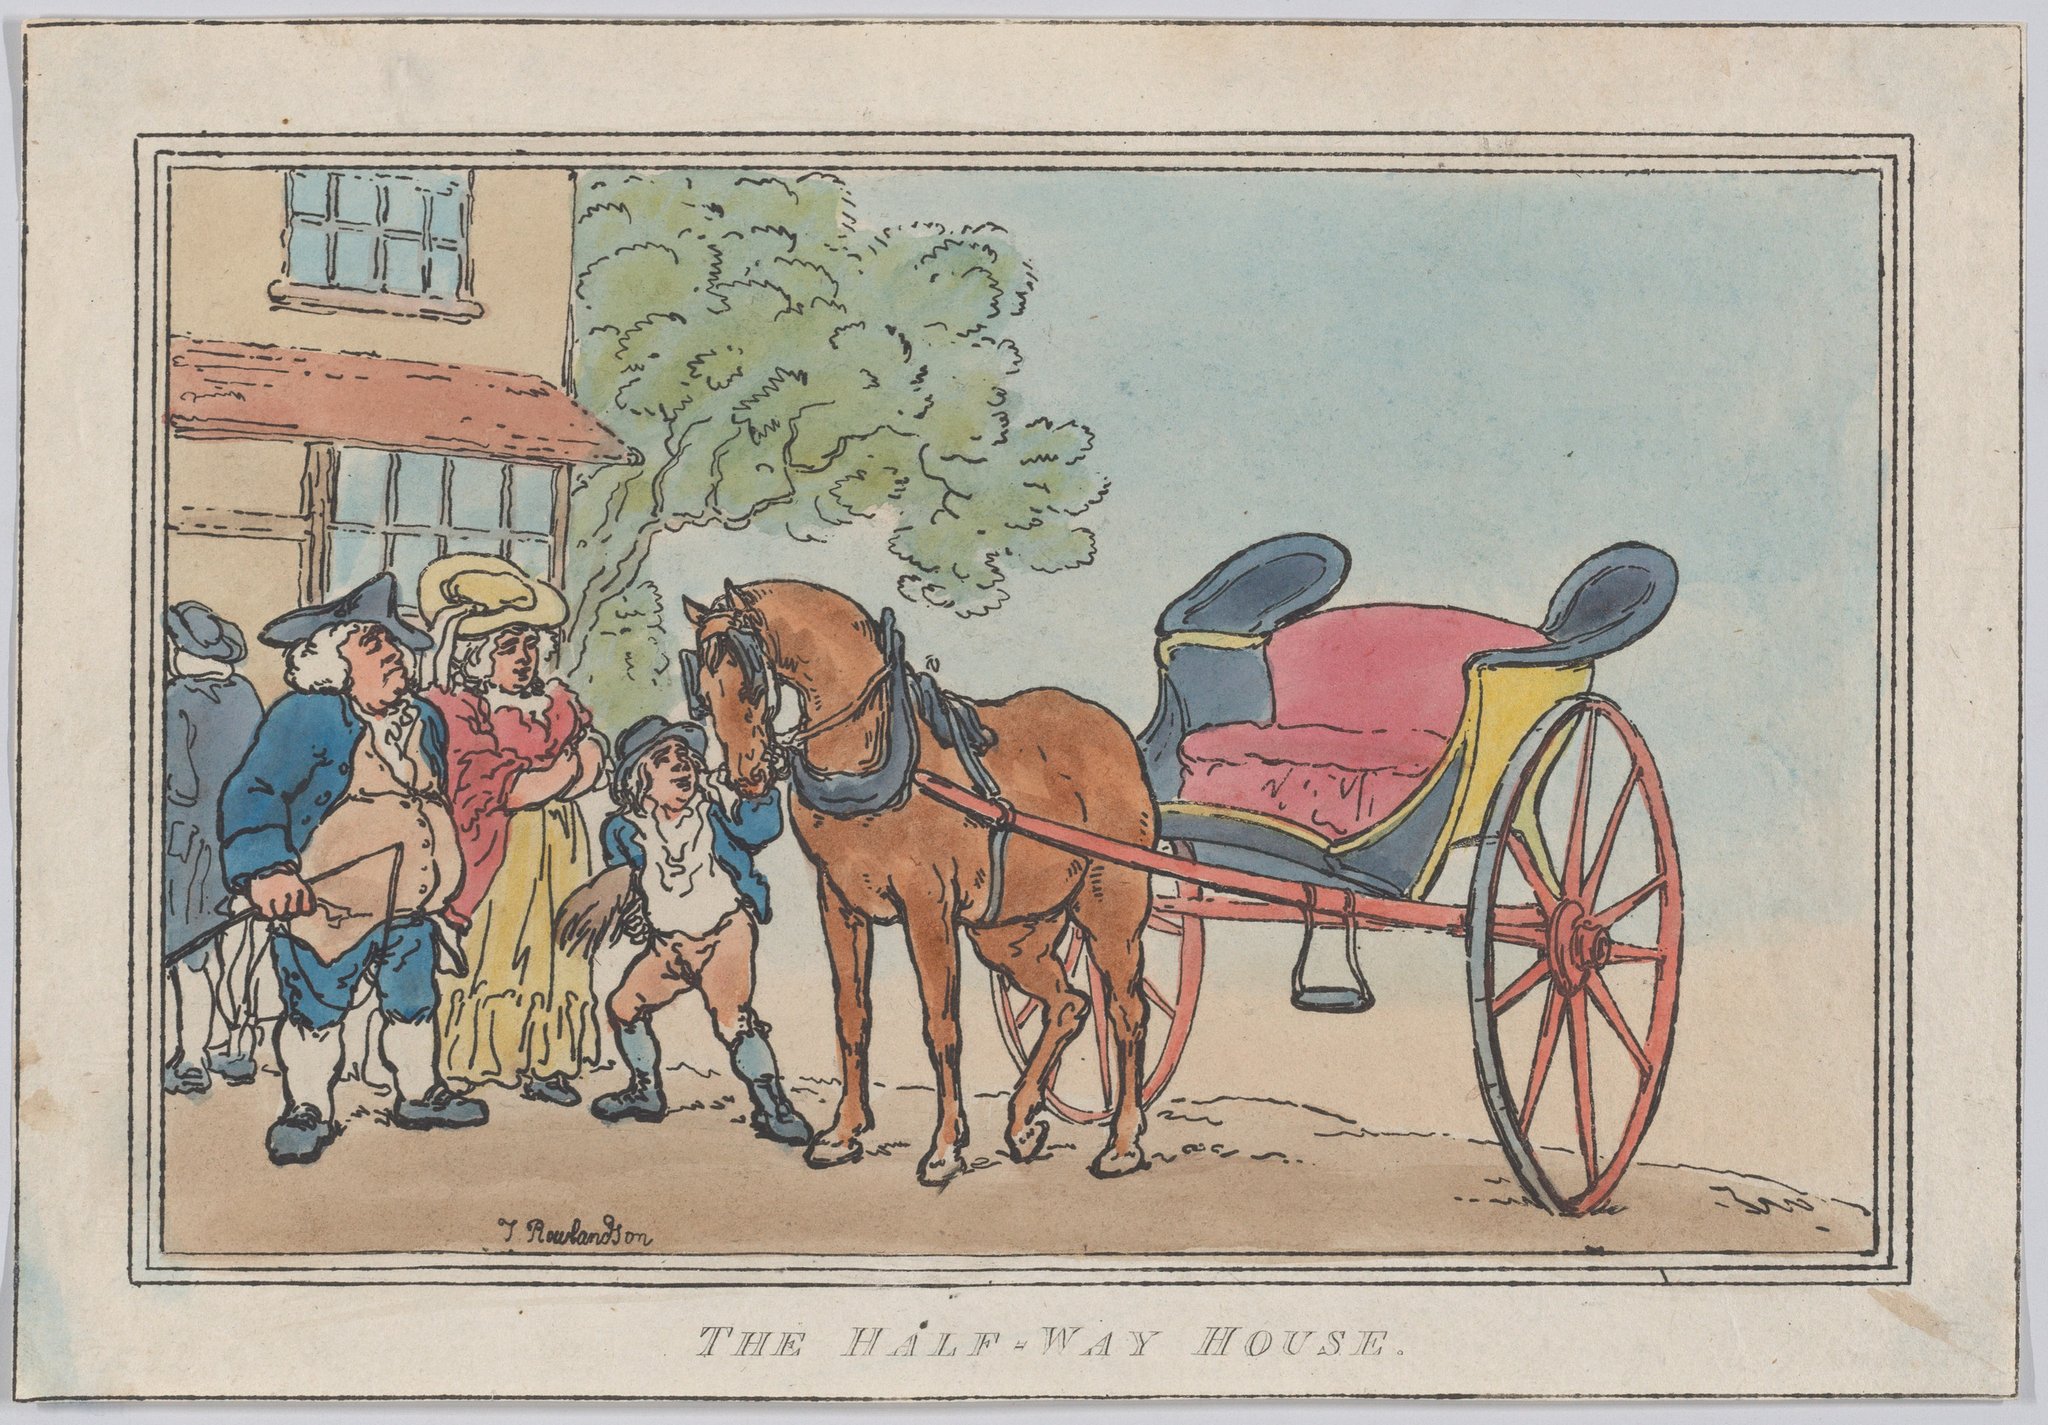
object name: print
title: The Half-Way House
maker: thomas rowlandson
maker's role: artist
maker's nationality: british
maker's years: 1757-1827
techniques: aquatint, etching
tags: men,women,horses,carriages